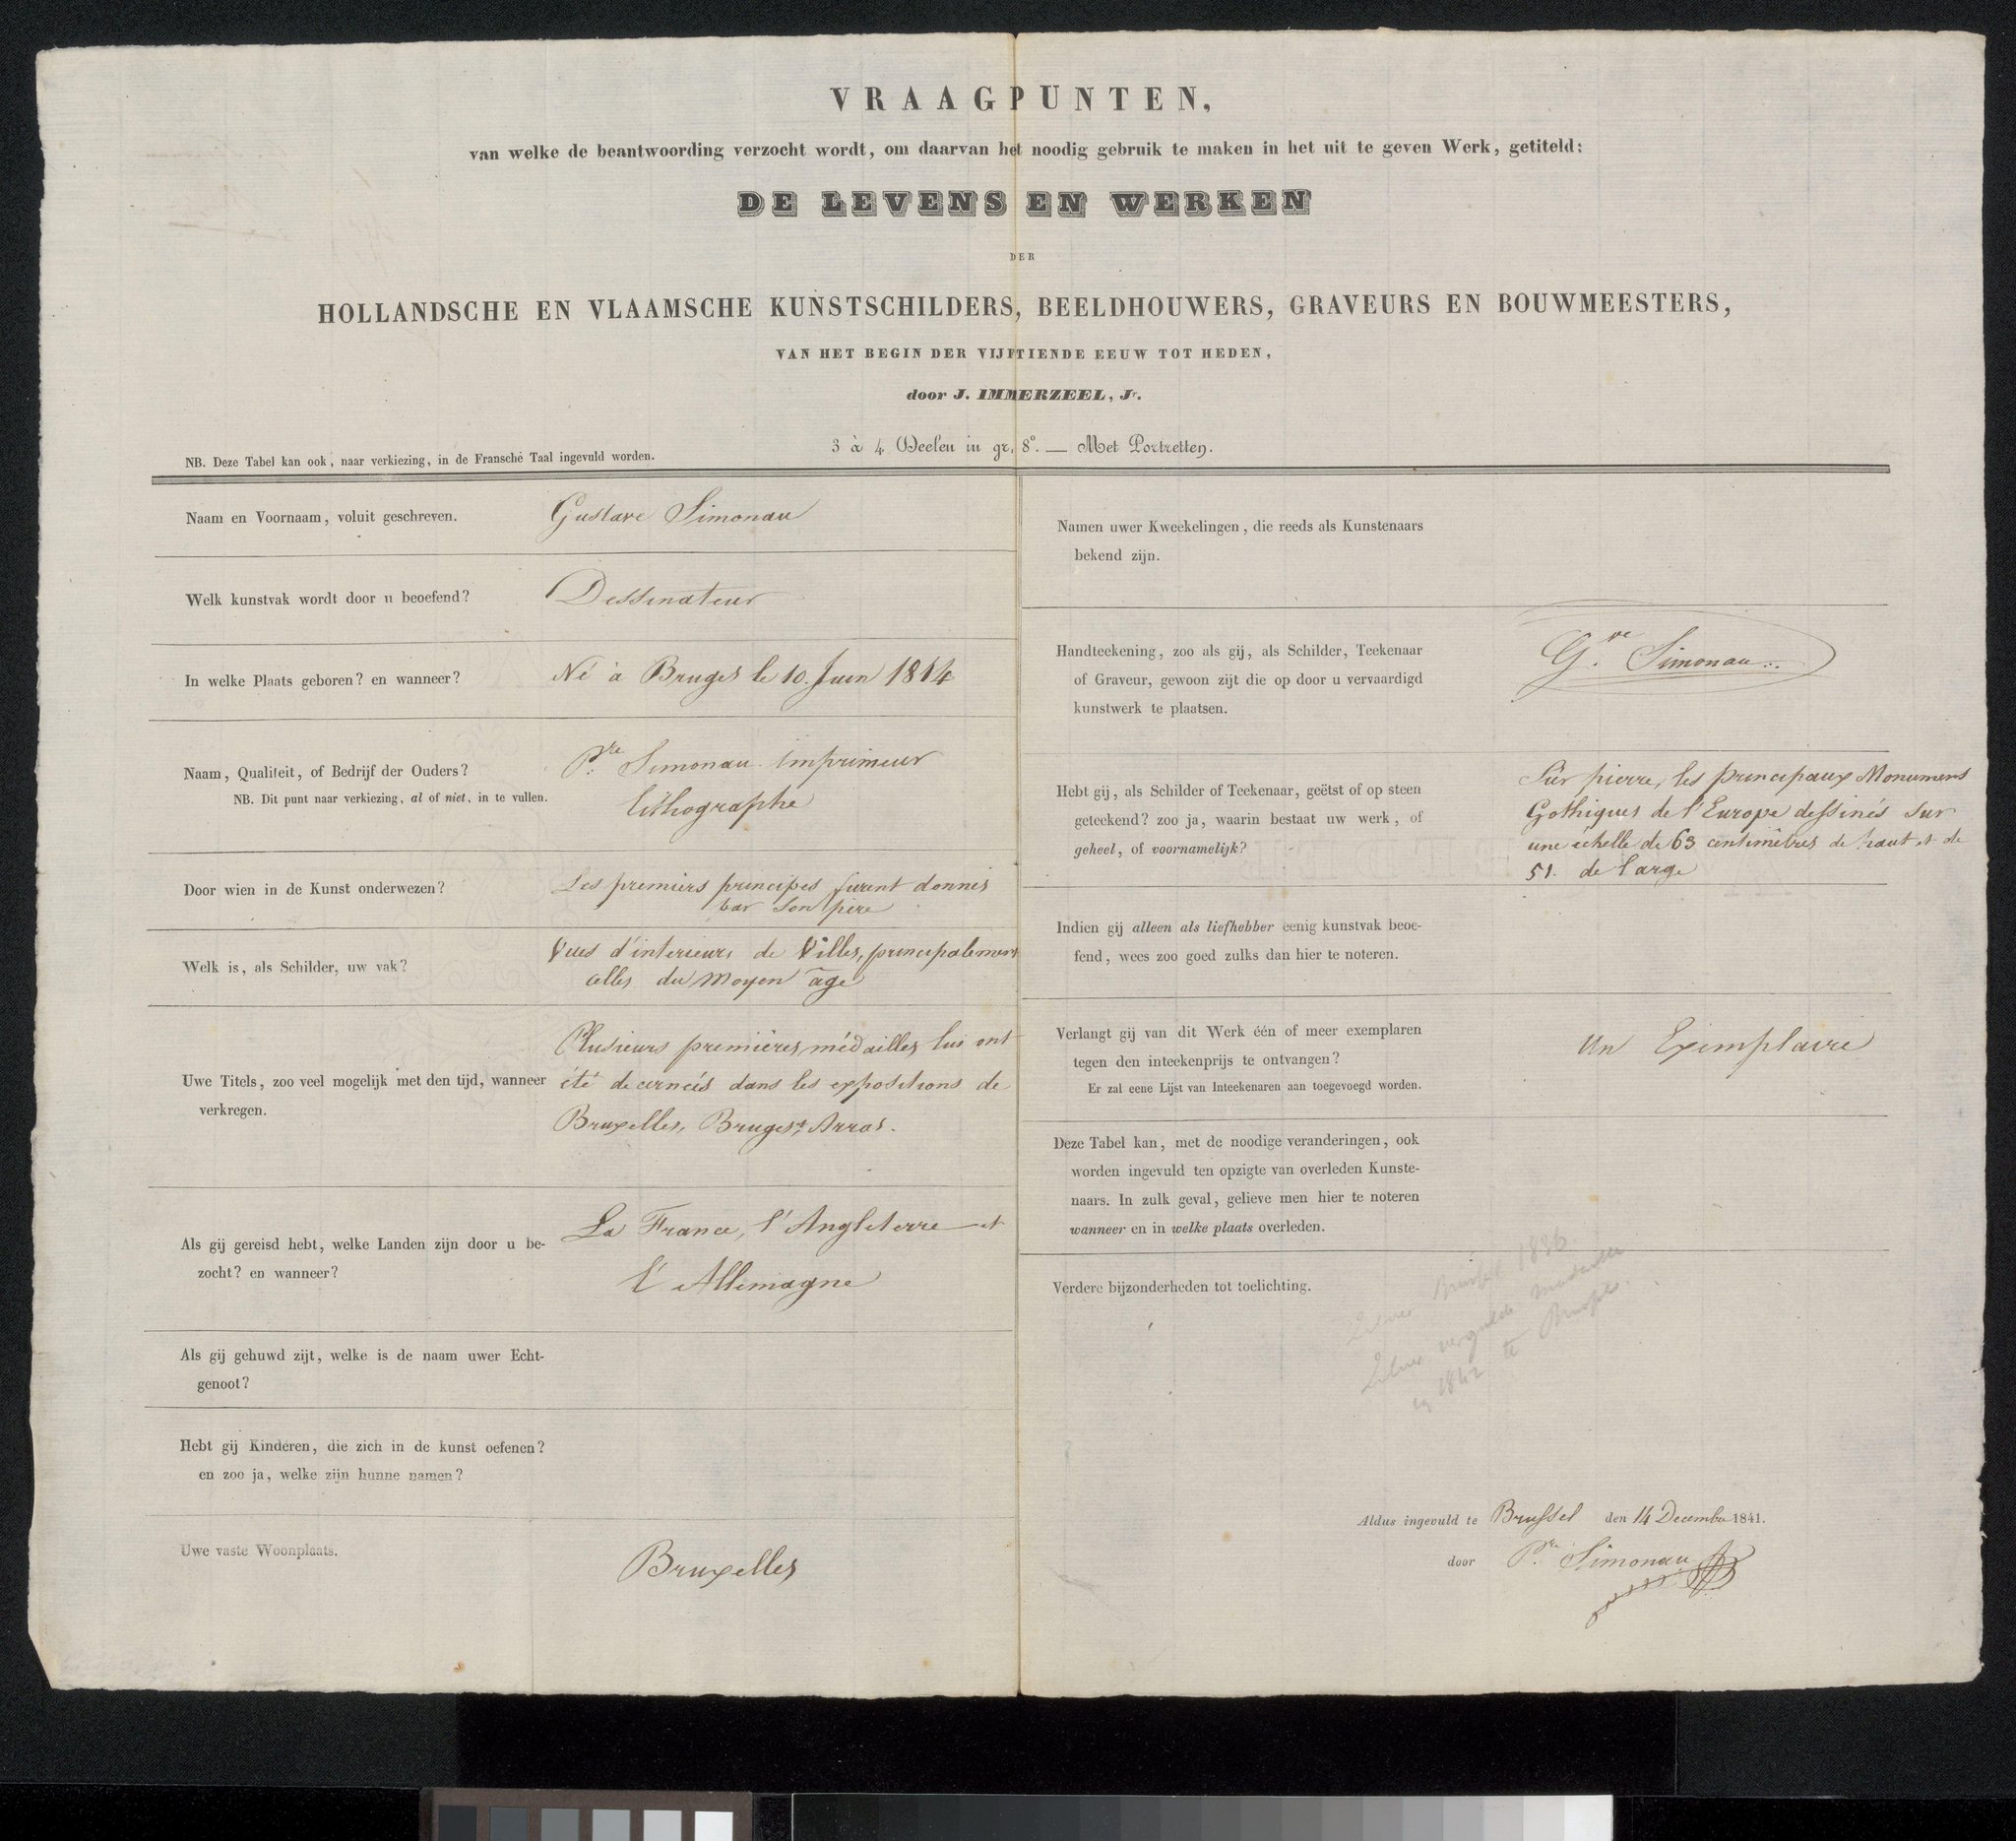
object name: manuscript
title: Enquêteformulier ingevuld door Gustave Adolphe Simonau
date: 1841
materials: ink, paper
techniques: pen, printing, writing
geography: brussels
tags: bruges, brussels, print maker, draughtsman, printer, publisher, gustave adolphe simonau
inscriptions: watermark, inscription: ‘Vraagpunten,/ van welke de beantwoording verzocht wordt, om daarvan het noodig gebruik te maken in het uit te geven Werk, getiteld: De levens en werken/ der Hollandsche en Vlaamsche kunstschilders, beeldhouwers,/ graveurs en bouwmeesters, van het begin der vijftiende eeuw tot heden/ door J. Immerzeel, Jr.’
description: Opgenomen in: Immerzeel, J. Jr., De levens en werken der Hollandsche en Vlaamsche kunstschilders, beeldhouwers, graveurs en bouwmeesters, van het begin der vijftiende eeuw tot heden, Amsterdam: J.C. van Kesteren, 1842-1843.